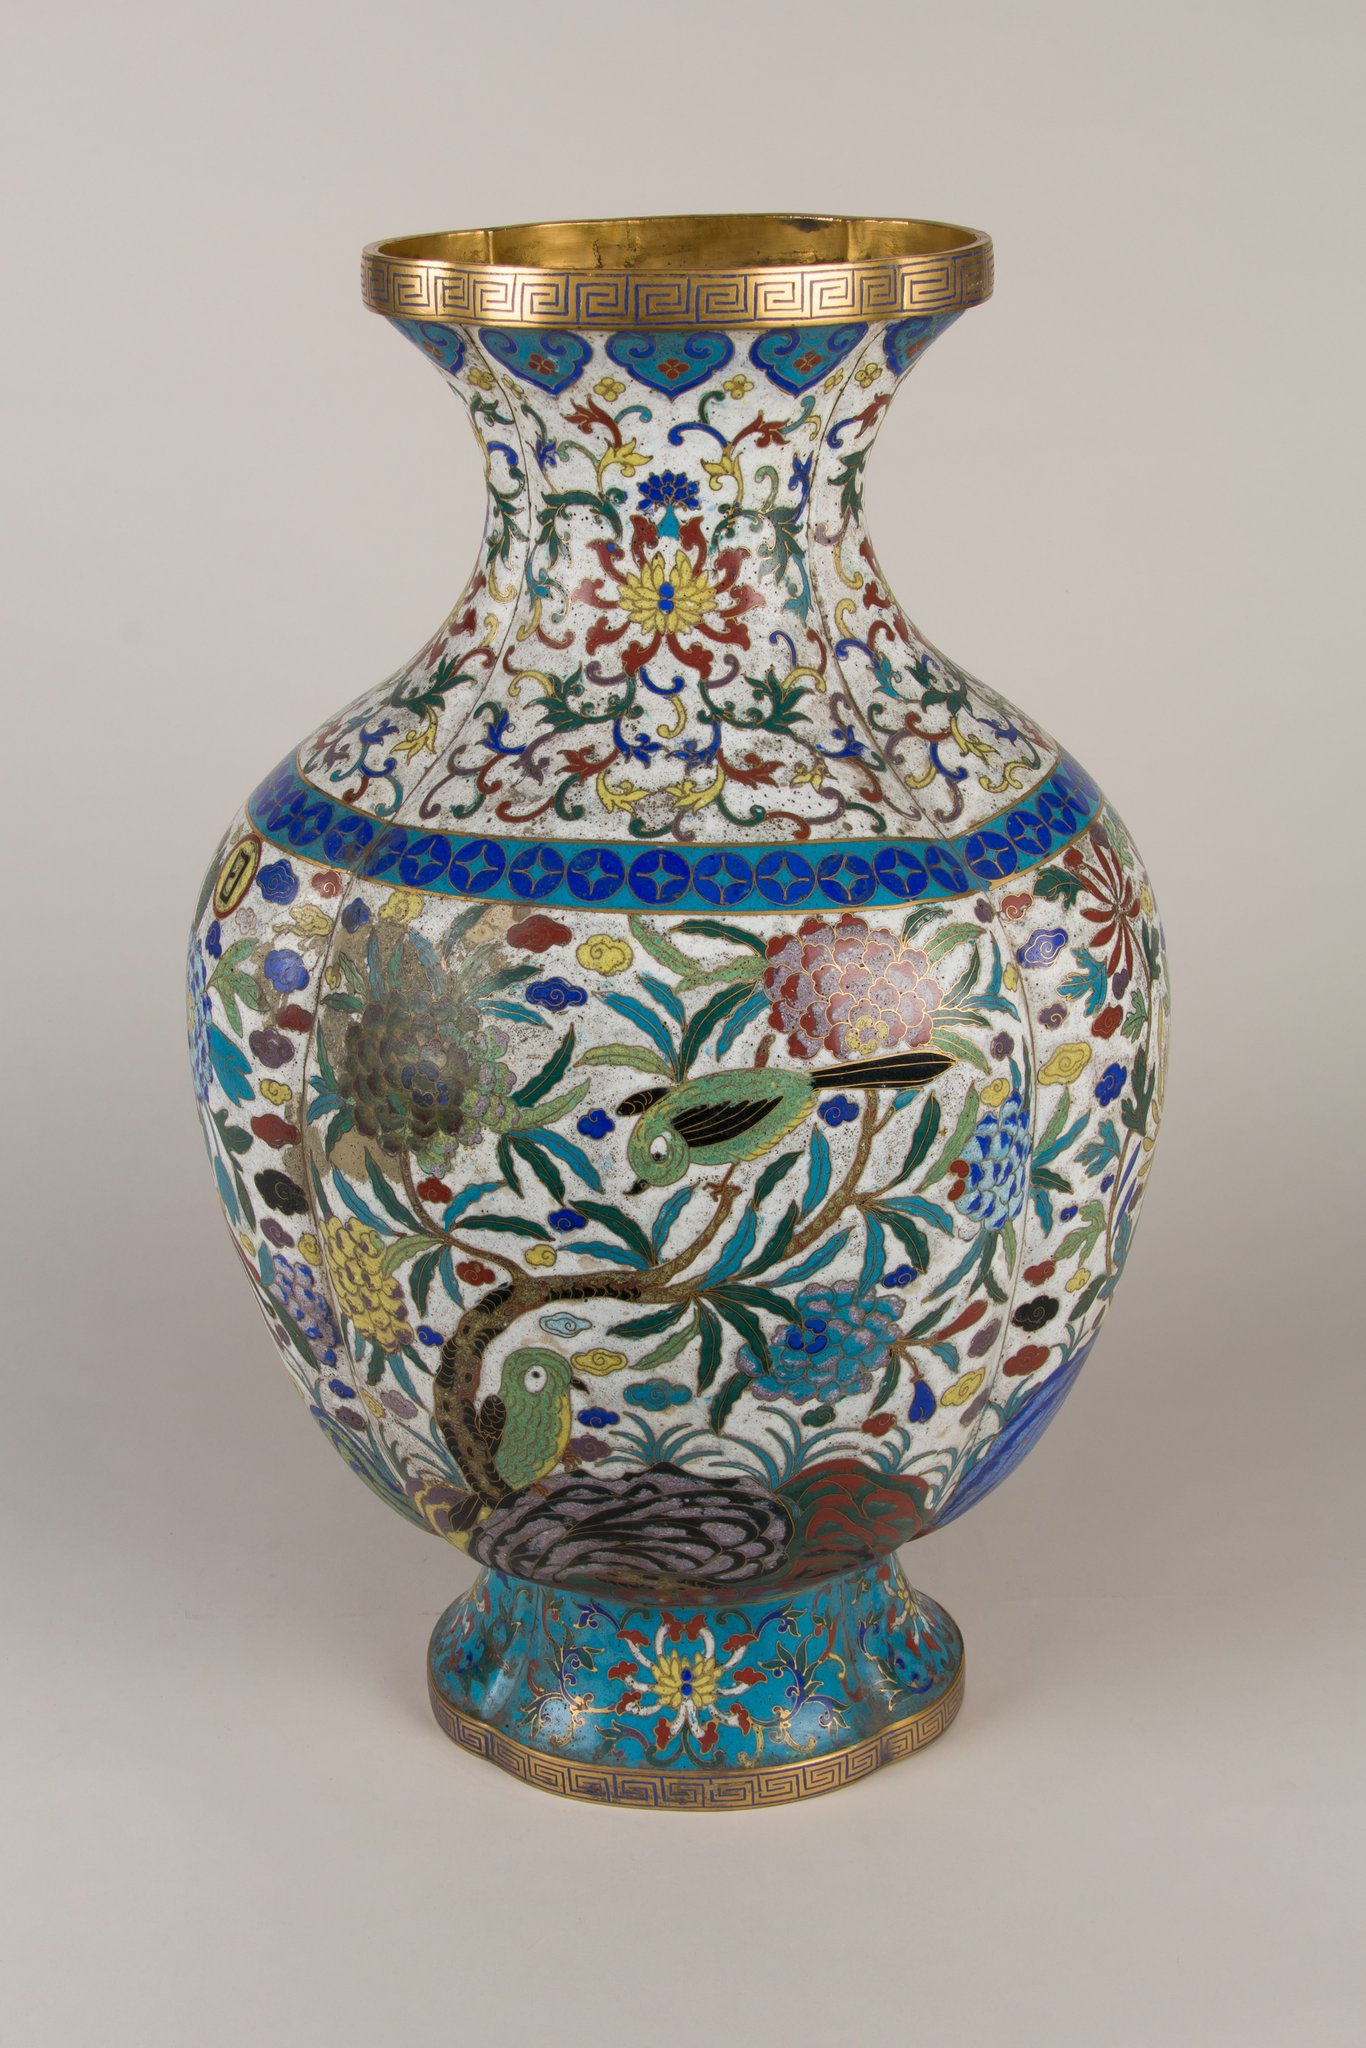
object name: vase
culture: chinese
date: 1736-1795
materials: copper, enamel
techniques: enamel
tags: birds,flowers